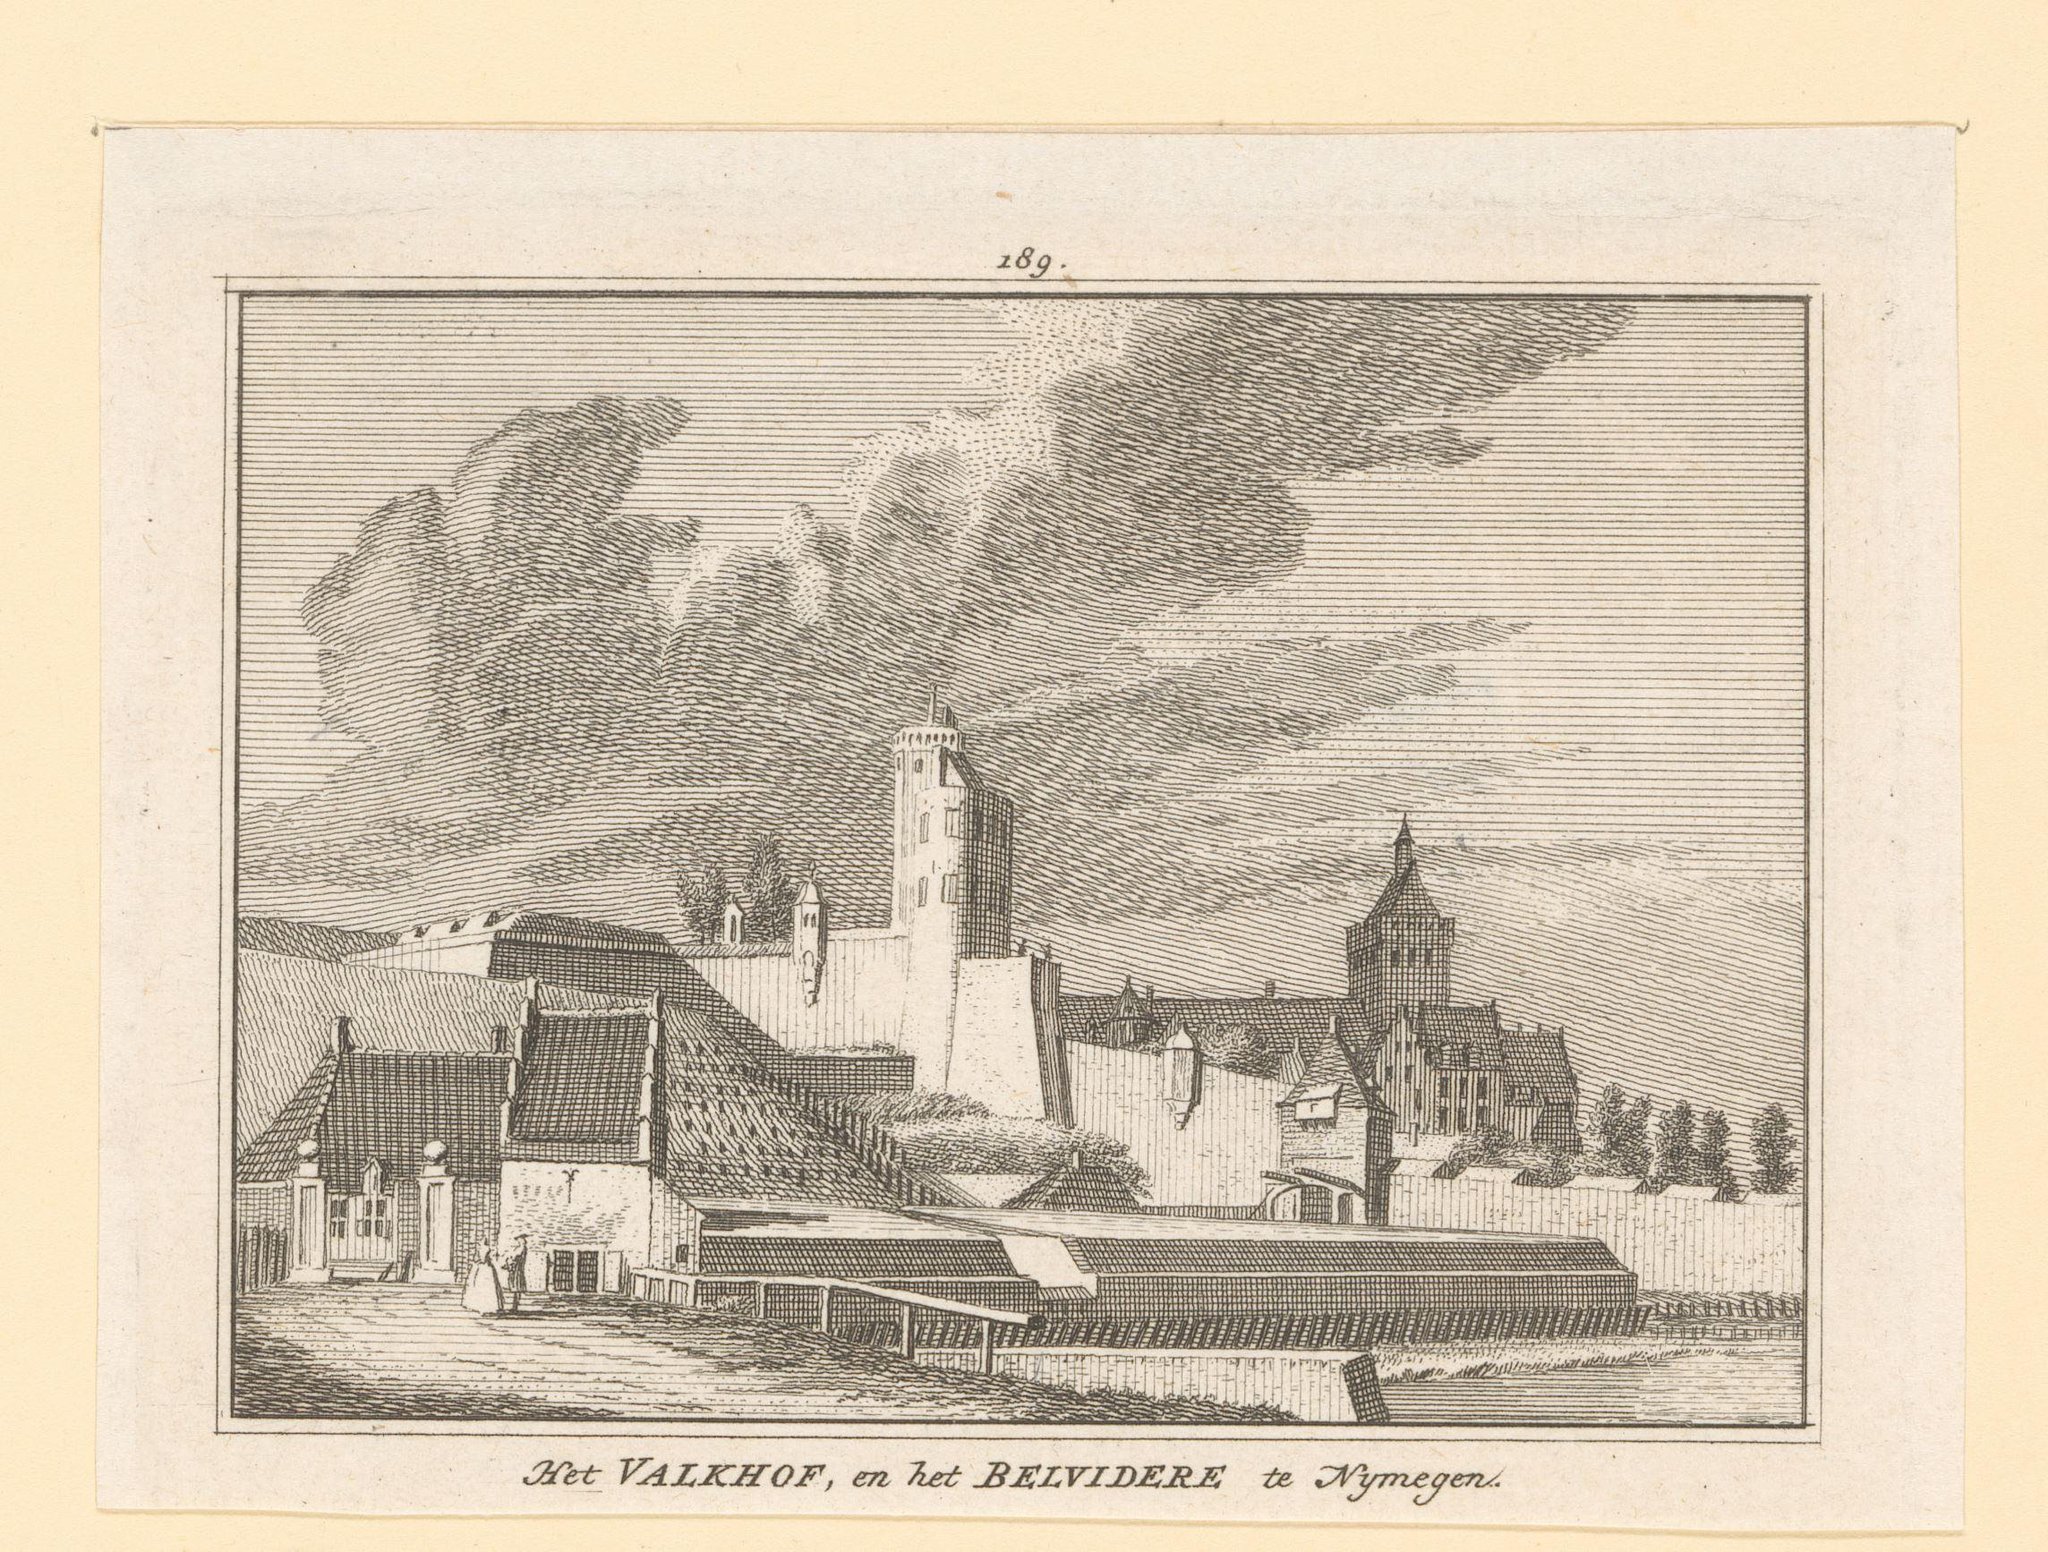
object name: print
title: Het Valkhof, en het Belvidere te Nymegen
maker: hendrik spilman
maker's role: draughtsman, painter, print maker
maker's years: 1721-1784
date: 1746-1792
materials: paper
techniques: etching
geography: amsterdam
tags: castle, towers ~ fortified city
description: Prent ook gebruikt in: Het verheerlykt Nederland of kabinet van hedendaagsche gezigten van steden, dorpen (…). 9 delen. Amsterdam: Isaak Tirion en weduwe Isaak Tirion, 1745-1774, dl. 2 (1746), ill. 189. Of in: Nederlandsche tafereelen; of eene keurige verzameling van negen honderd fraaije gezigten van steden, dorpen, sloten, oudheden (….). 9 delen. Amsterdam: Jan de Groot, 1792, dl. 2, ill. 189.